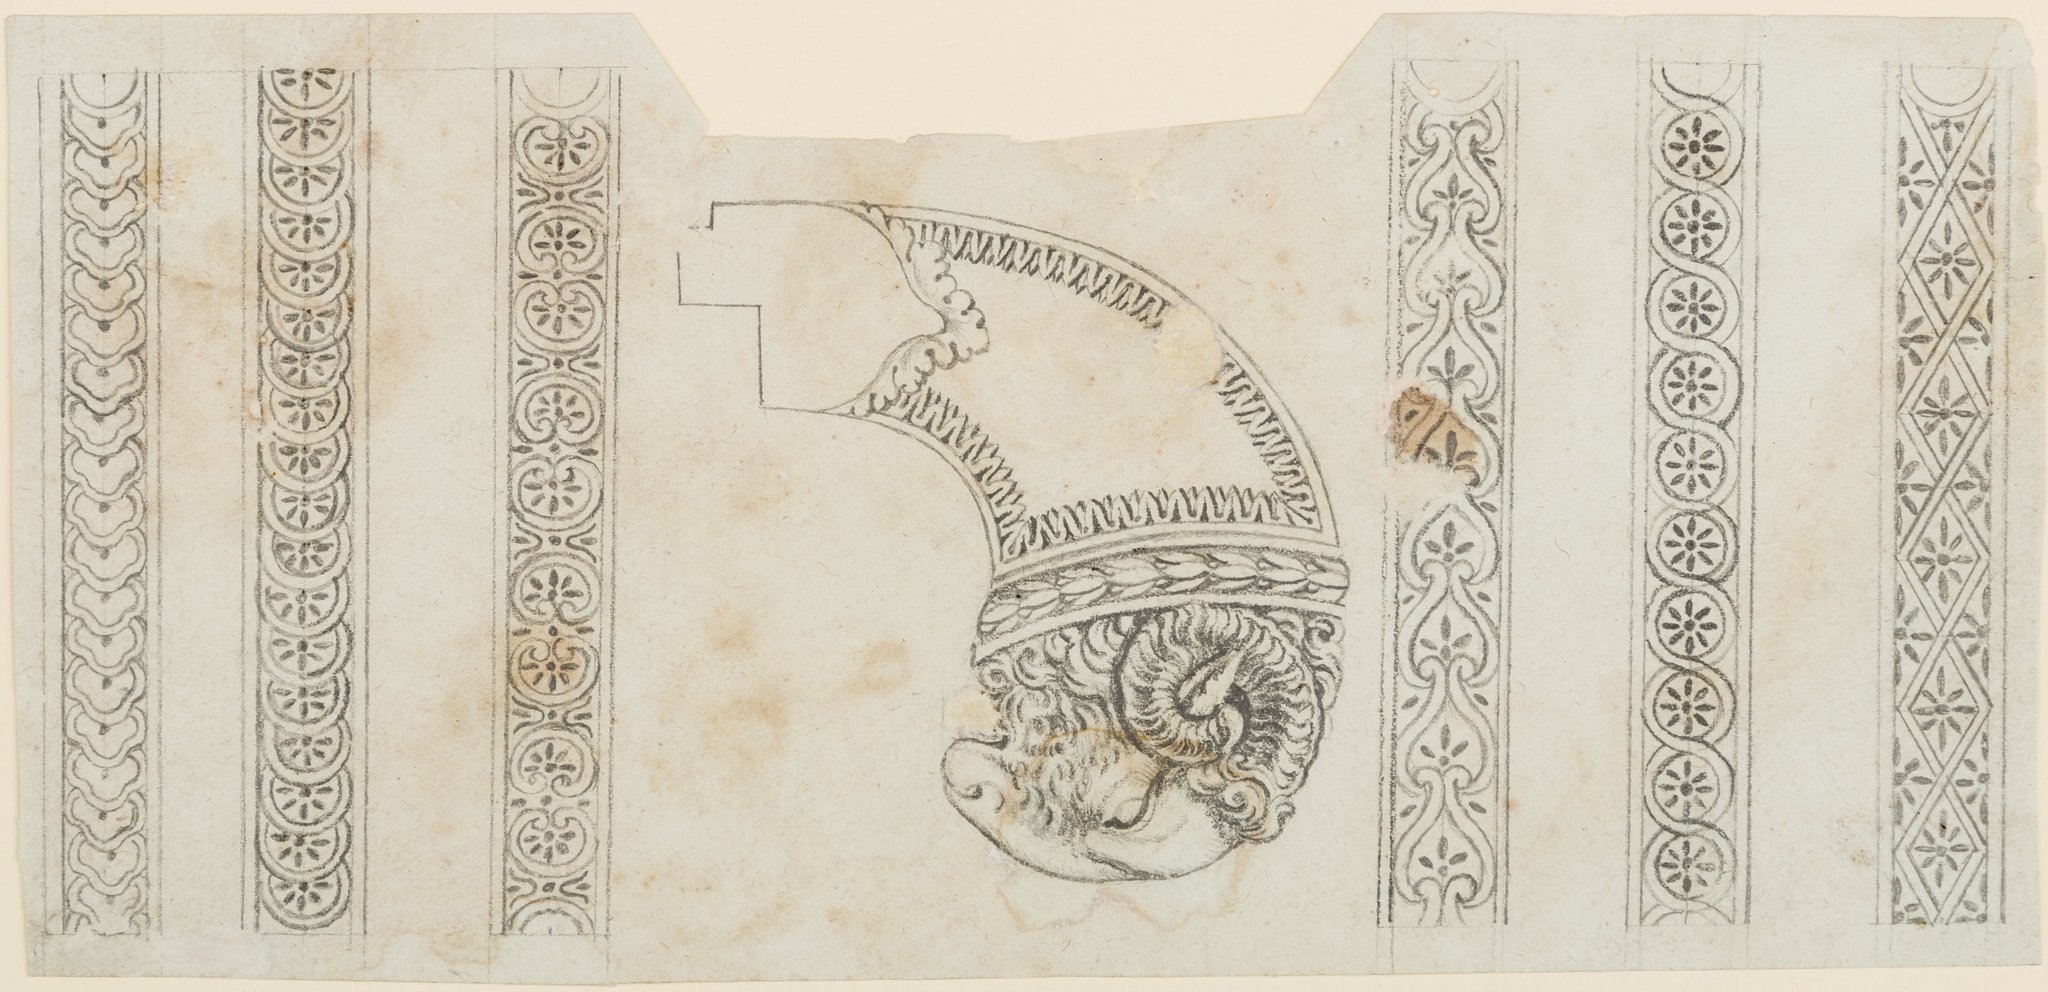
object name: drawing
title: Design for the Decoration of a Pistol Grip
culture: french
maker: nicolas noël boutet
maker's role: designer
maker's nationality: french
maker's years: 1761-1833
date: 1797-1805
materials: ink, paper, pencil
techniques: wash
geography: france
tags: rams